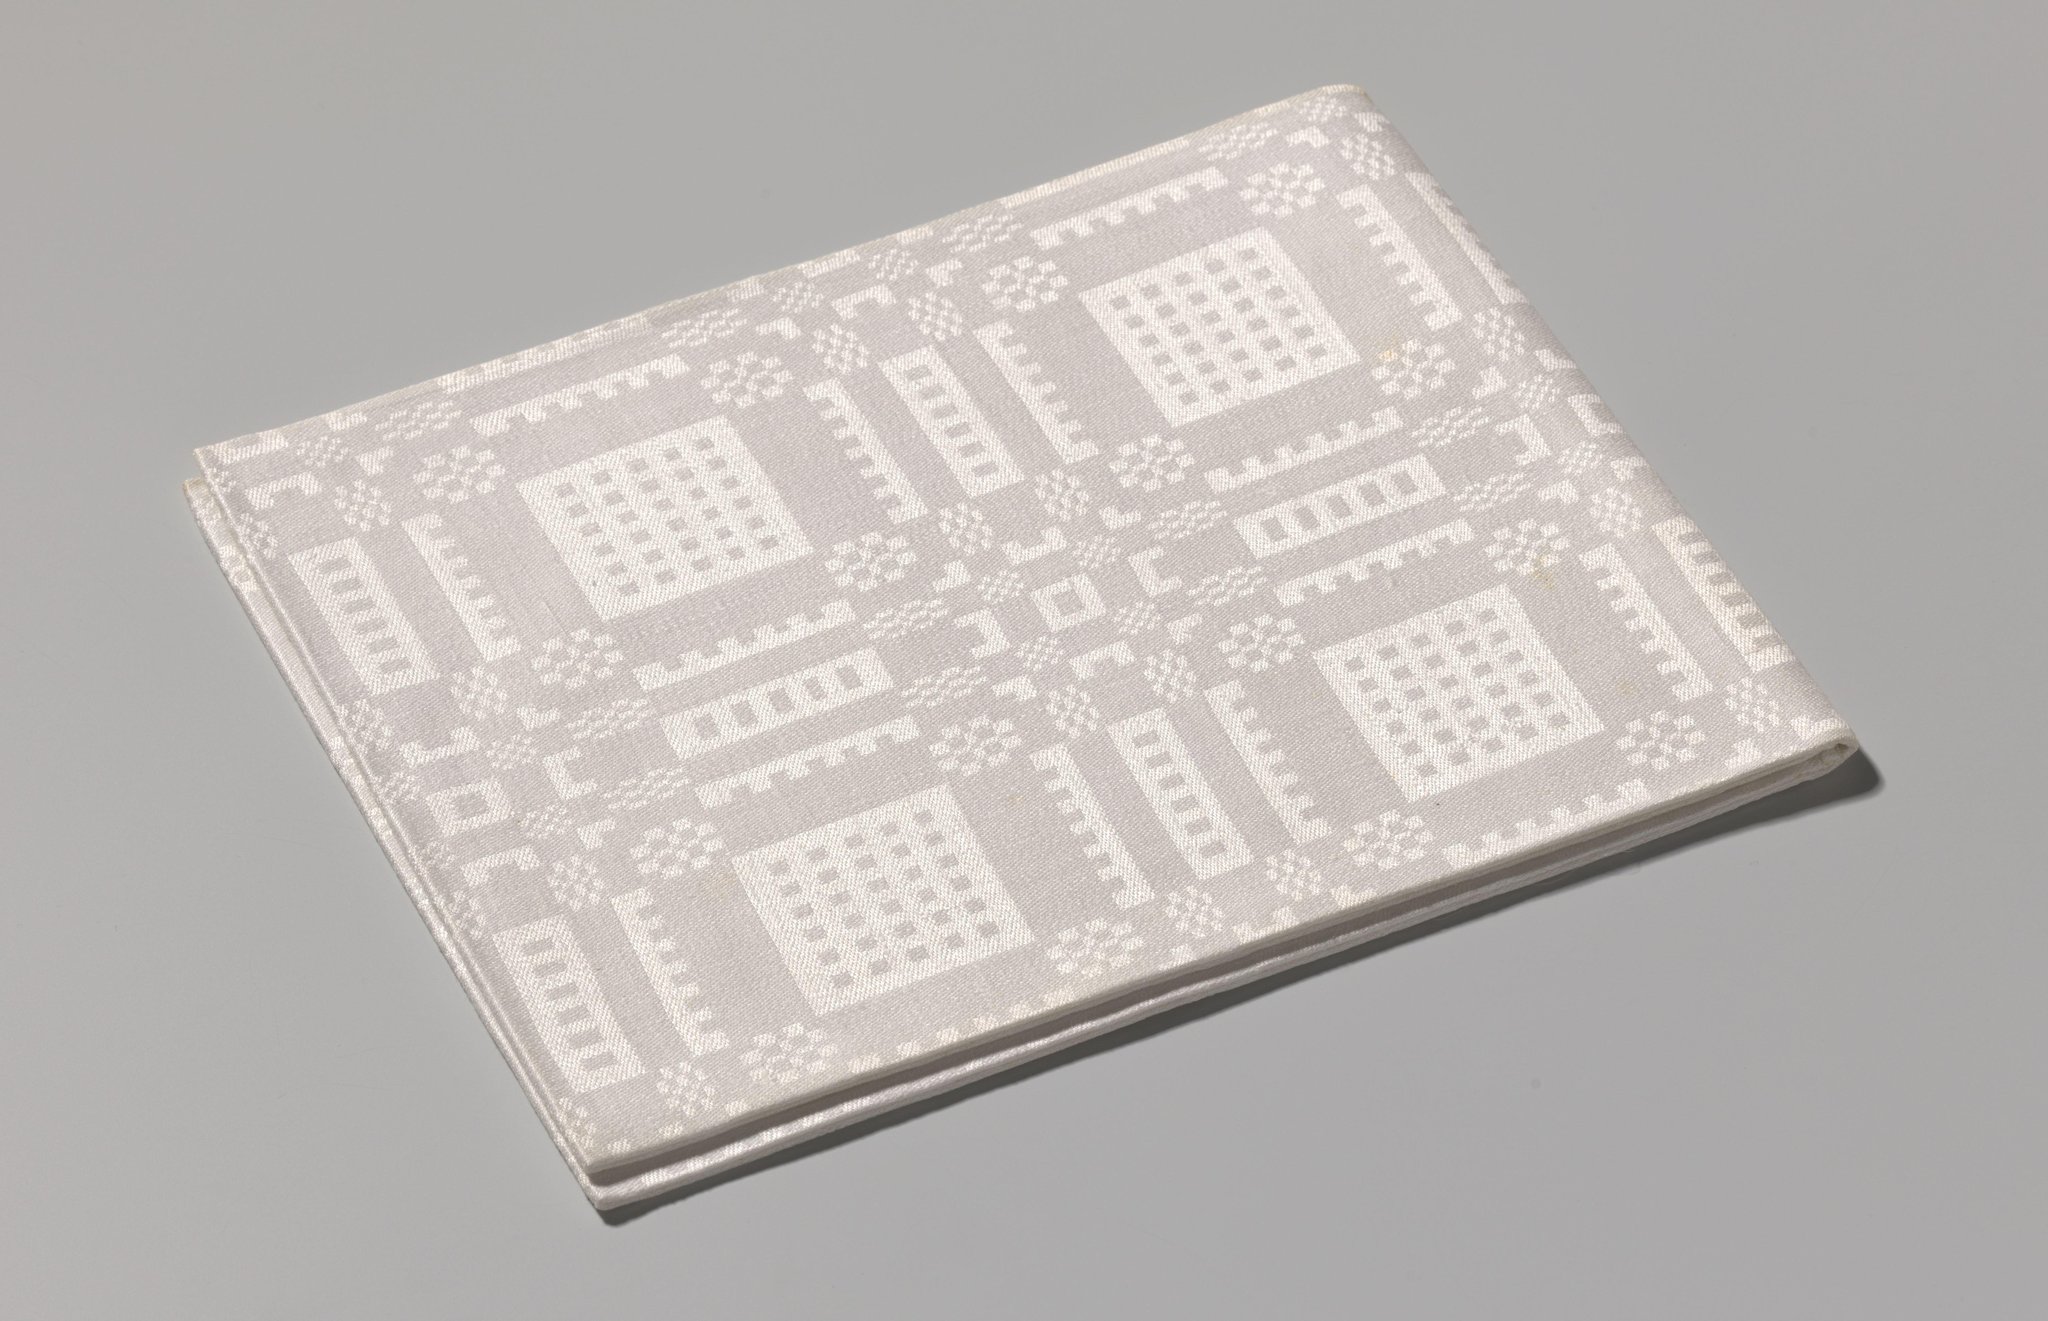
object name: napkin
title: Servet met pellenpatroon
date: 1756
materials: linen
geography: northern netherlands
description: Servet van wit linnen met pellenpatroon, merk kroon G 30 en 1756.